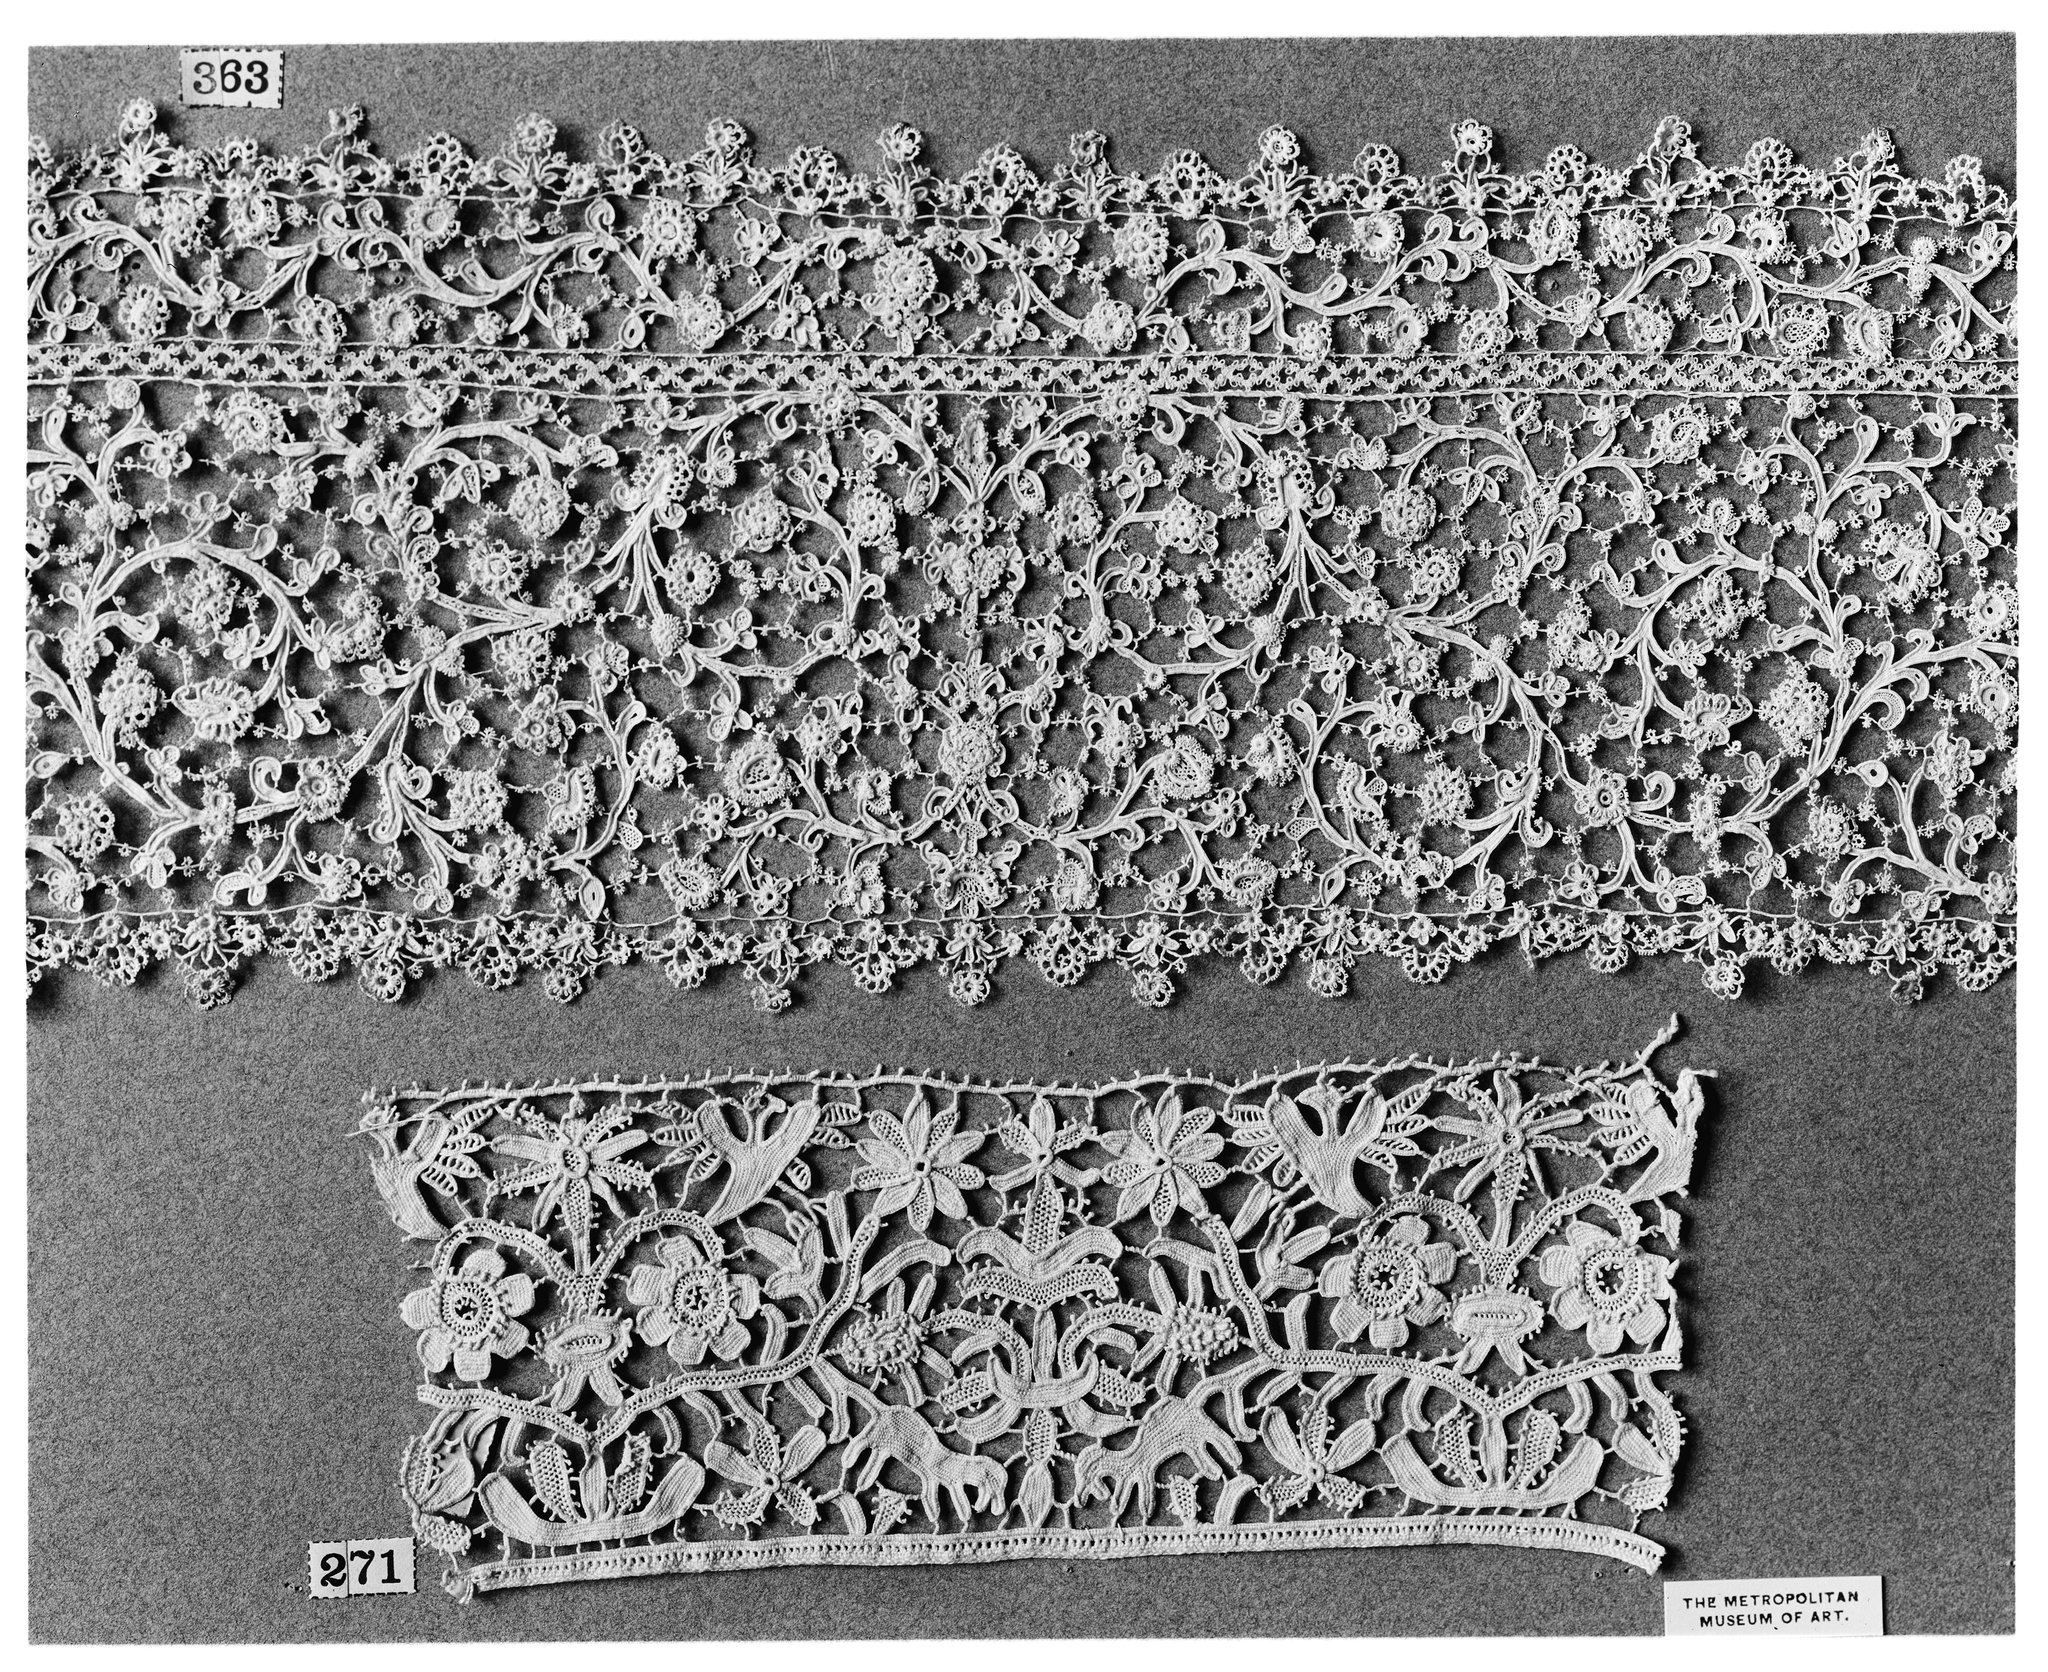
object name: neckpiece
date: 1701-1733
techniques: lace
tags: flowers